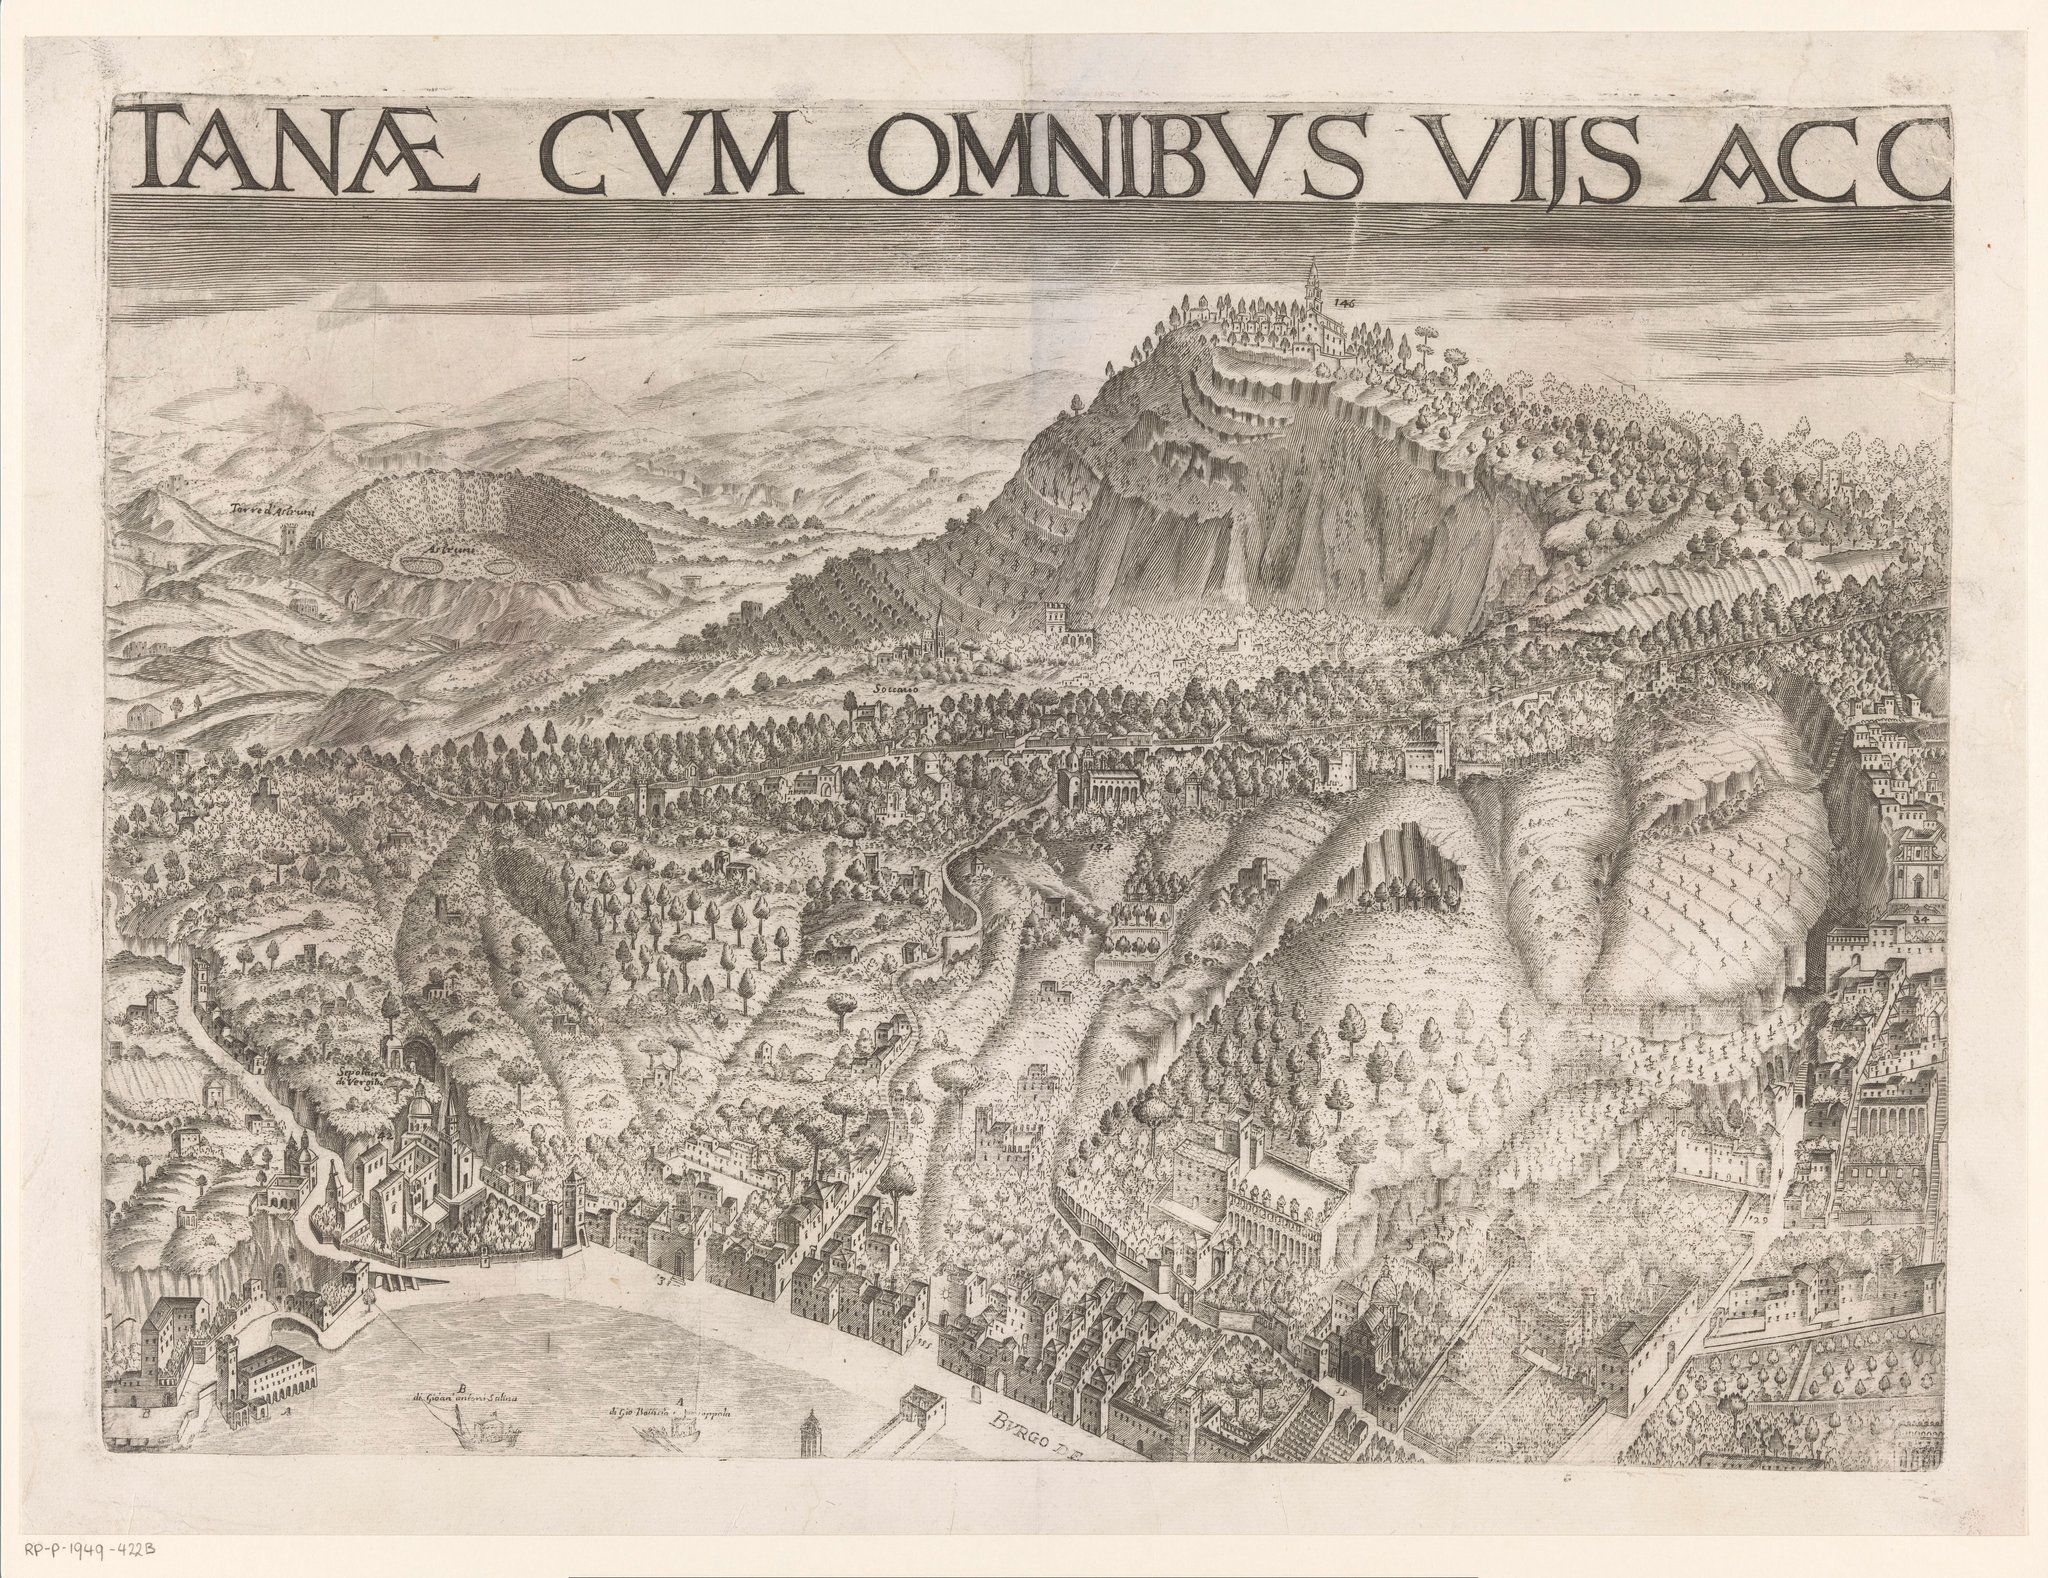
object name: print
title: Detail van een gezicht op Napels in vogelvluchtperspectief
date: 1629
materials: paper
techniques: engraving, etching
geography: naples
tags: city-view in general; 'veduta', volcano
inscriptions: collector's mark: Lugt 2228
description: Deze prent maakt onderdeel uit van een gezicht op Napels in vogelvluchtperspectief. De gehele voorstelling wordt gevormd door zestien prenten. Hiervan bevinden zich zes prenten in de collectie van het Rijksmuseum.